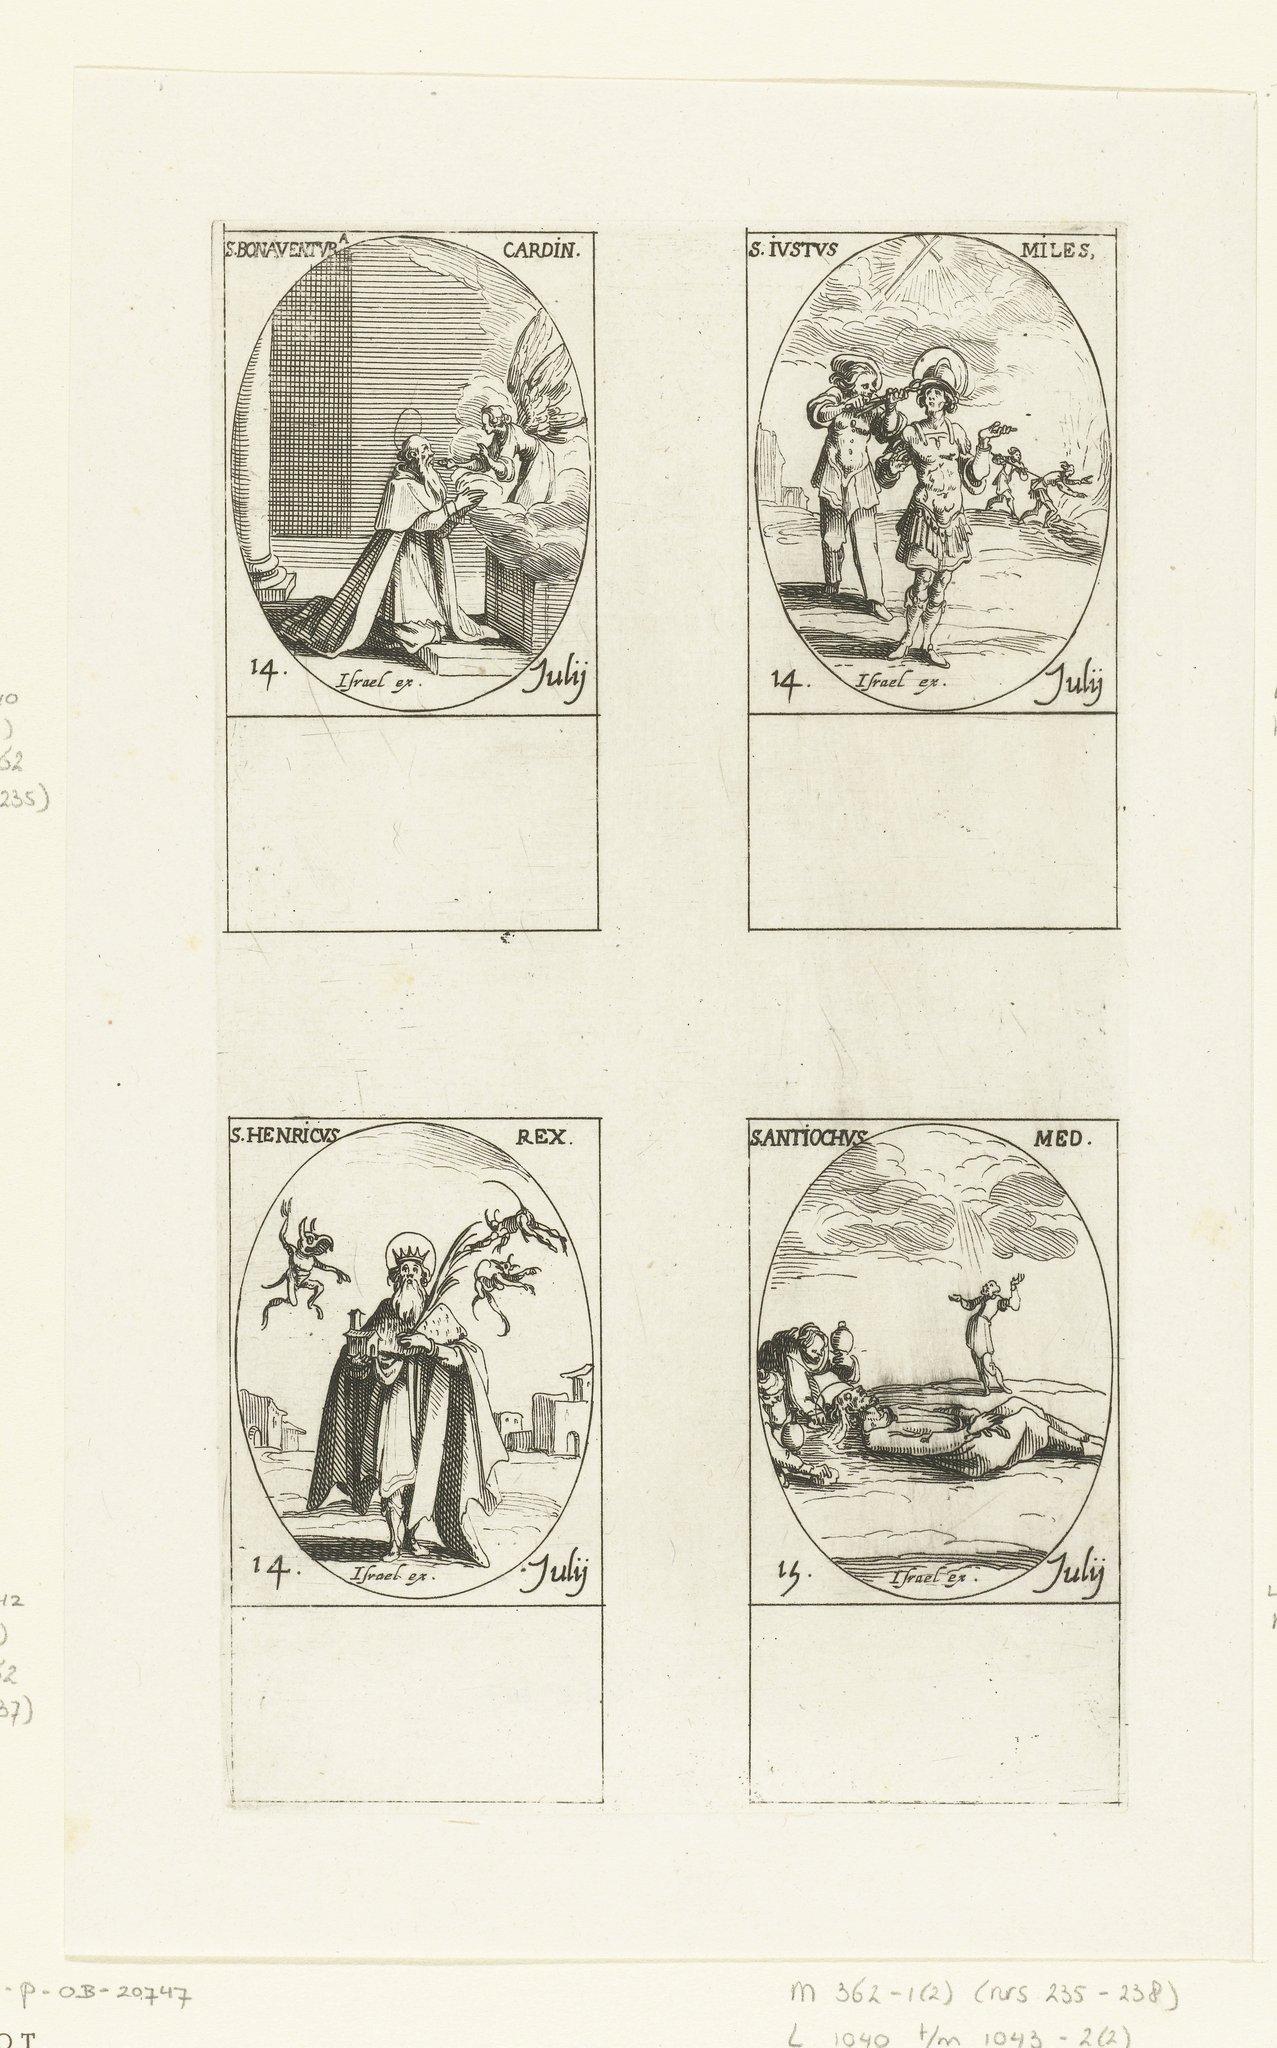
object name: print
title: Alle heiligen en de Christelijke feestdagen van het jaar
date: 1632-1636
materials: paper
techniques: etching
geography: nancy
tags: male saints (with name), an angel gives st. bonaventura the sacrament ('angel communion')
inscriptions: collector's mark: Lugt 240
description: Blad met vier ovale voorstellingen, elk met opschrift en datum in het Latijn: linksboven de Heilige Bonaventura die een hostie van een engel ontvangt, rechtsboven de Heilige Justus in harnas die gemarteld wordt met een tang, linksonder de Heilige Henricus II van Duitsland met kroon op het hoofd en kerkmodel in de hand die geplaagd wordt door duivelse wezens, rechtsonder de Heilige Antiochus van Sebaste op de grond liggend met twee vrouwen gehurkt bij zijn hoofd. Deze prent is onderdeel van een serie prenten met voorstellingen van de heiligen en de christelijke feestdagen van het jaar. Er zijn steeds vier scènes van één plaat op één blad gedrukt. Inclusief bijbehorend titelblad en frontispice gaat het in totaal om 124 platen (490 voorstellingen). De drie platen met de laatste 12 scènes (de veranderlijke christelijke feestdagen) zijn in de derde staat versneden tot 12 kleine plaatjes, en met een apart titelblad uitgegeven.